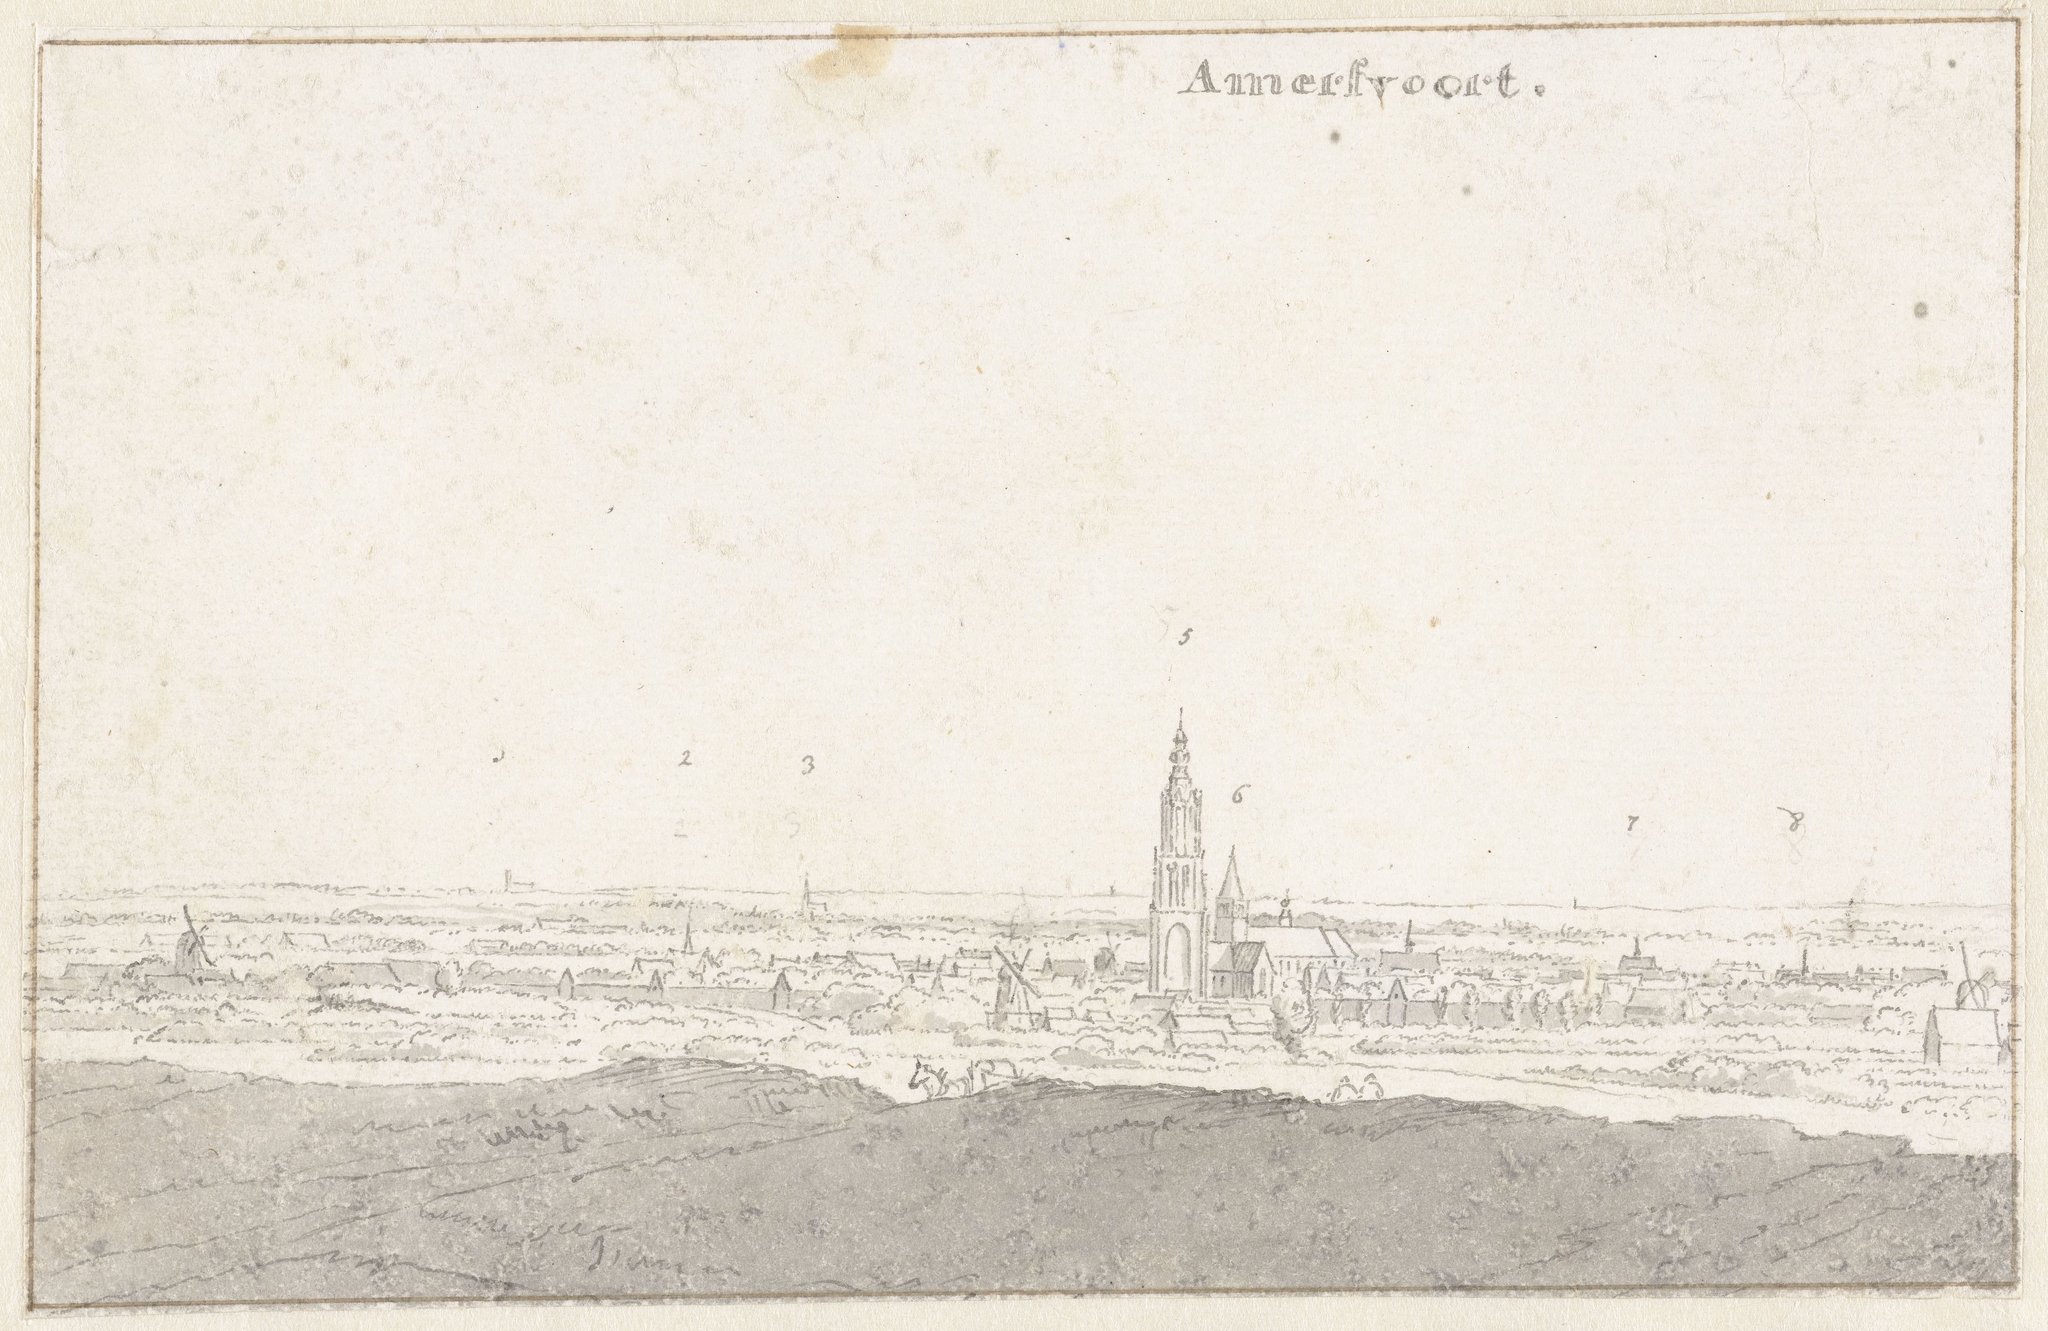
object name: drawing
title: Gezicht op Amersfoort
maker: cornelis pronk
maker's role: draughtsman, painter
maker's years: 1691-1759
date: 1701-1759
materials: ink, paper, pencil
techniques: brush, pen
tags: city-view, and landscape with man-made constructions